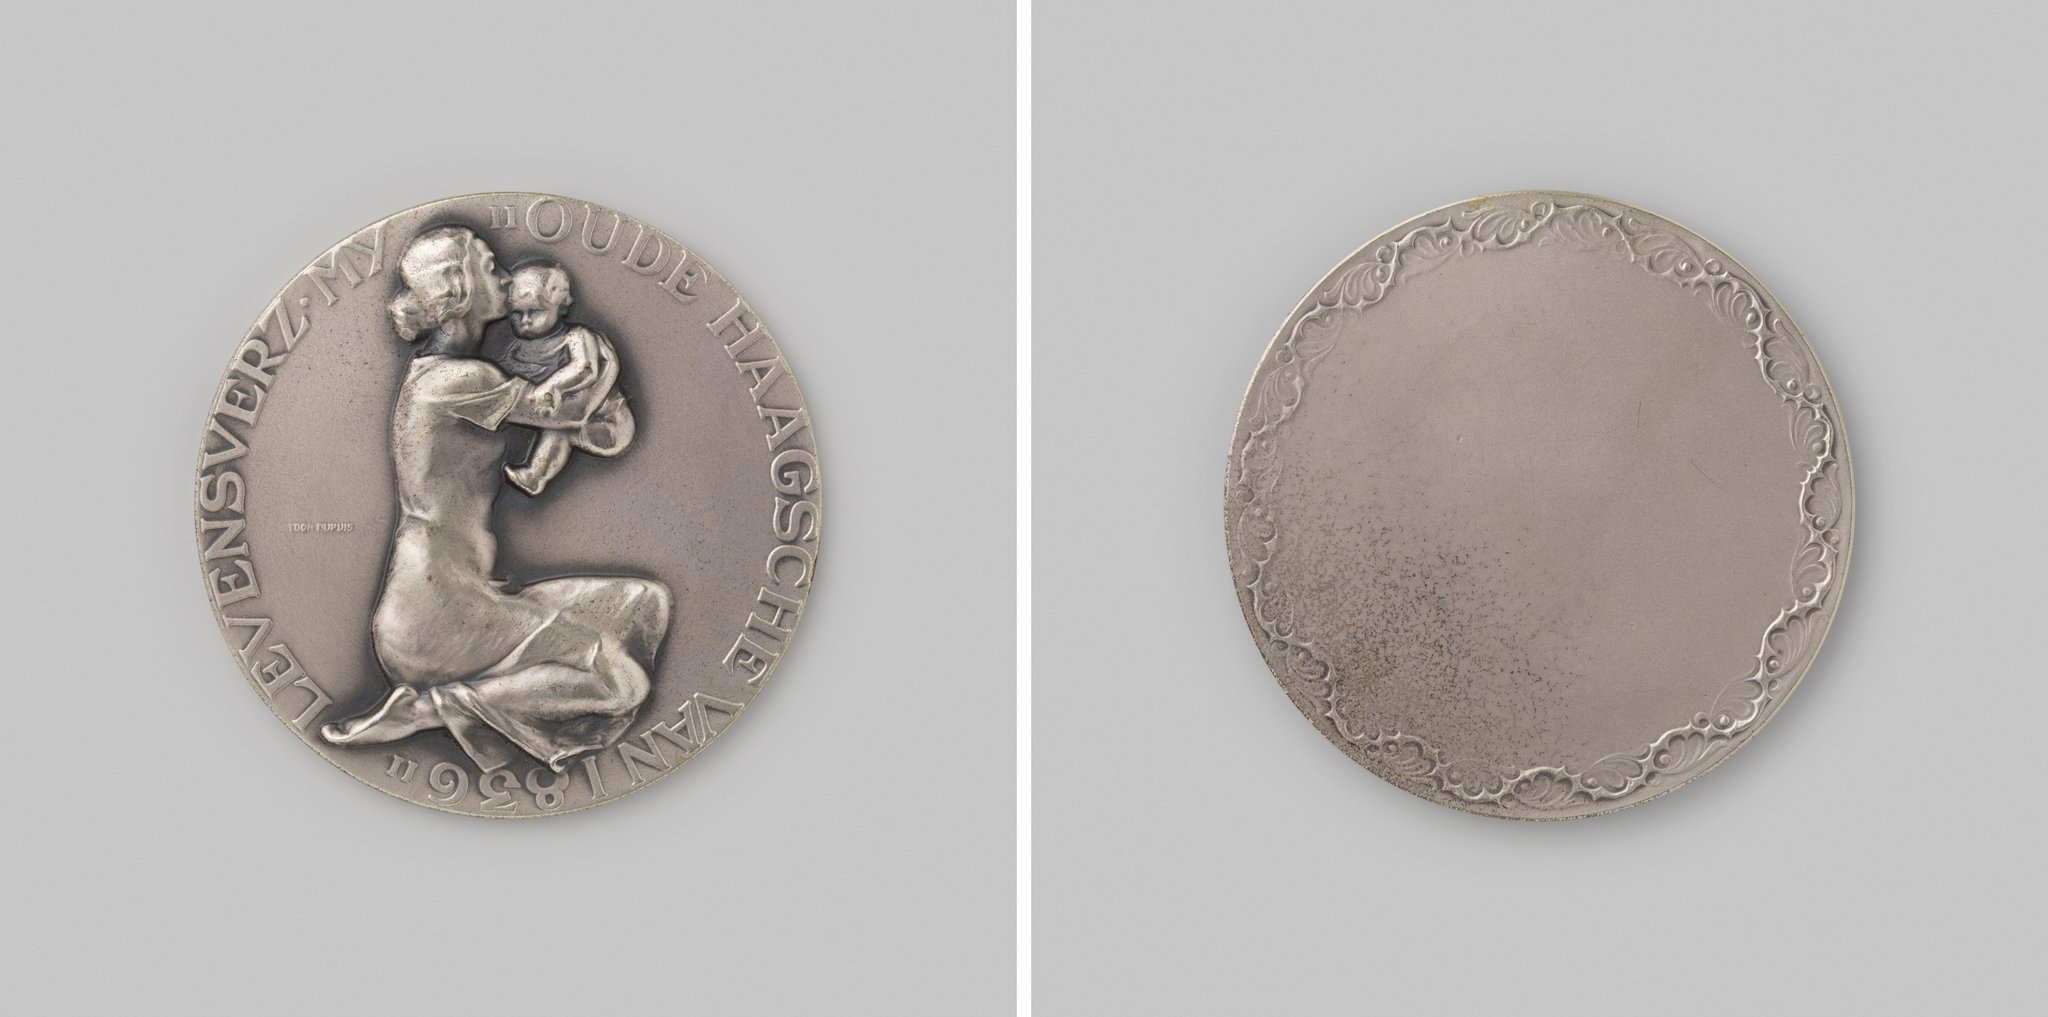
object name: medal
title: 100-Jarig bestaan van de Levensverzekeringsmaatschappij 'Oude Haagsche van 1836'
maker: toon dupuis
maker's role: sculptor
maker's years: 1877-1937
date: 1936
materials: silver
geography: netherlands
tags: mother and baby or young child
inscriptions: signature: ‘TOON DUPUIS’, circumscription: ‘LEVESNSVERZ.MY "OUDE HAAGSCHE VAN 1836"’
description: Zilveren penning. Voorzijde een knielende vrouw en profil naar rechts met klein kind in de armen die zij een kus geeft, binnen omschrift; keerzijde: leeg veld binnen rankenmotief. Met bijbehorende doos NG-2008-6-2.